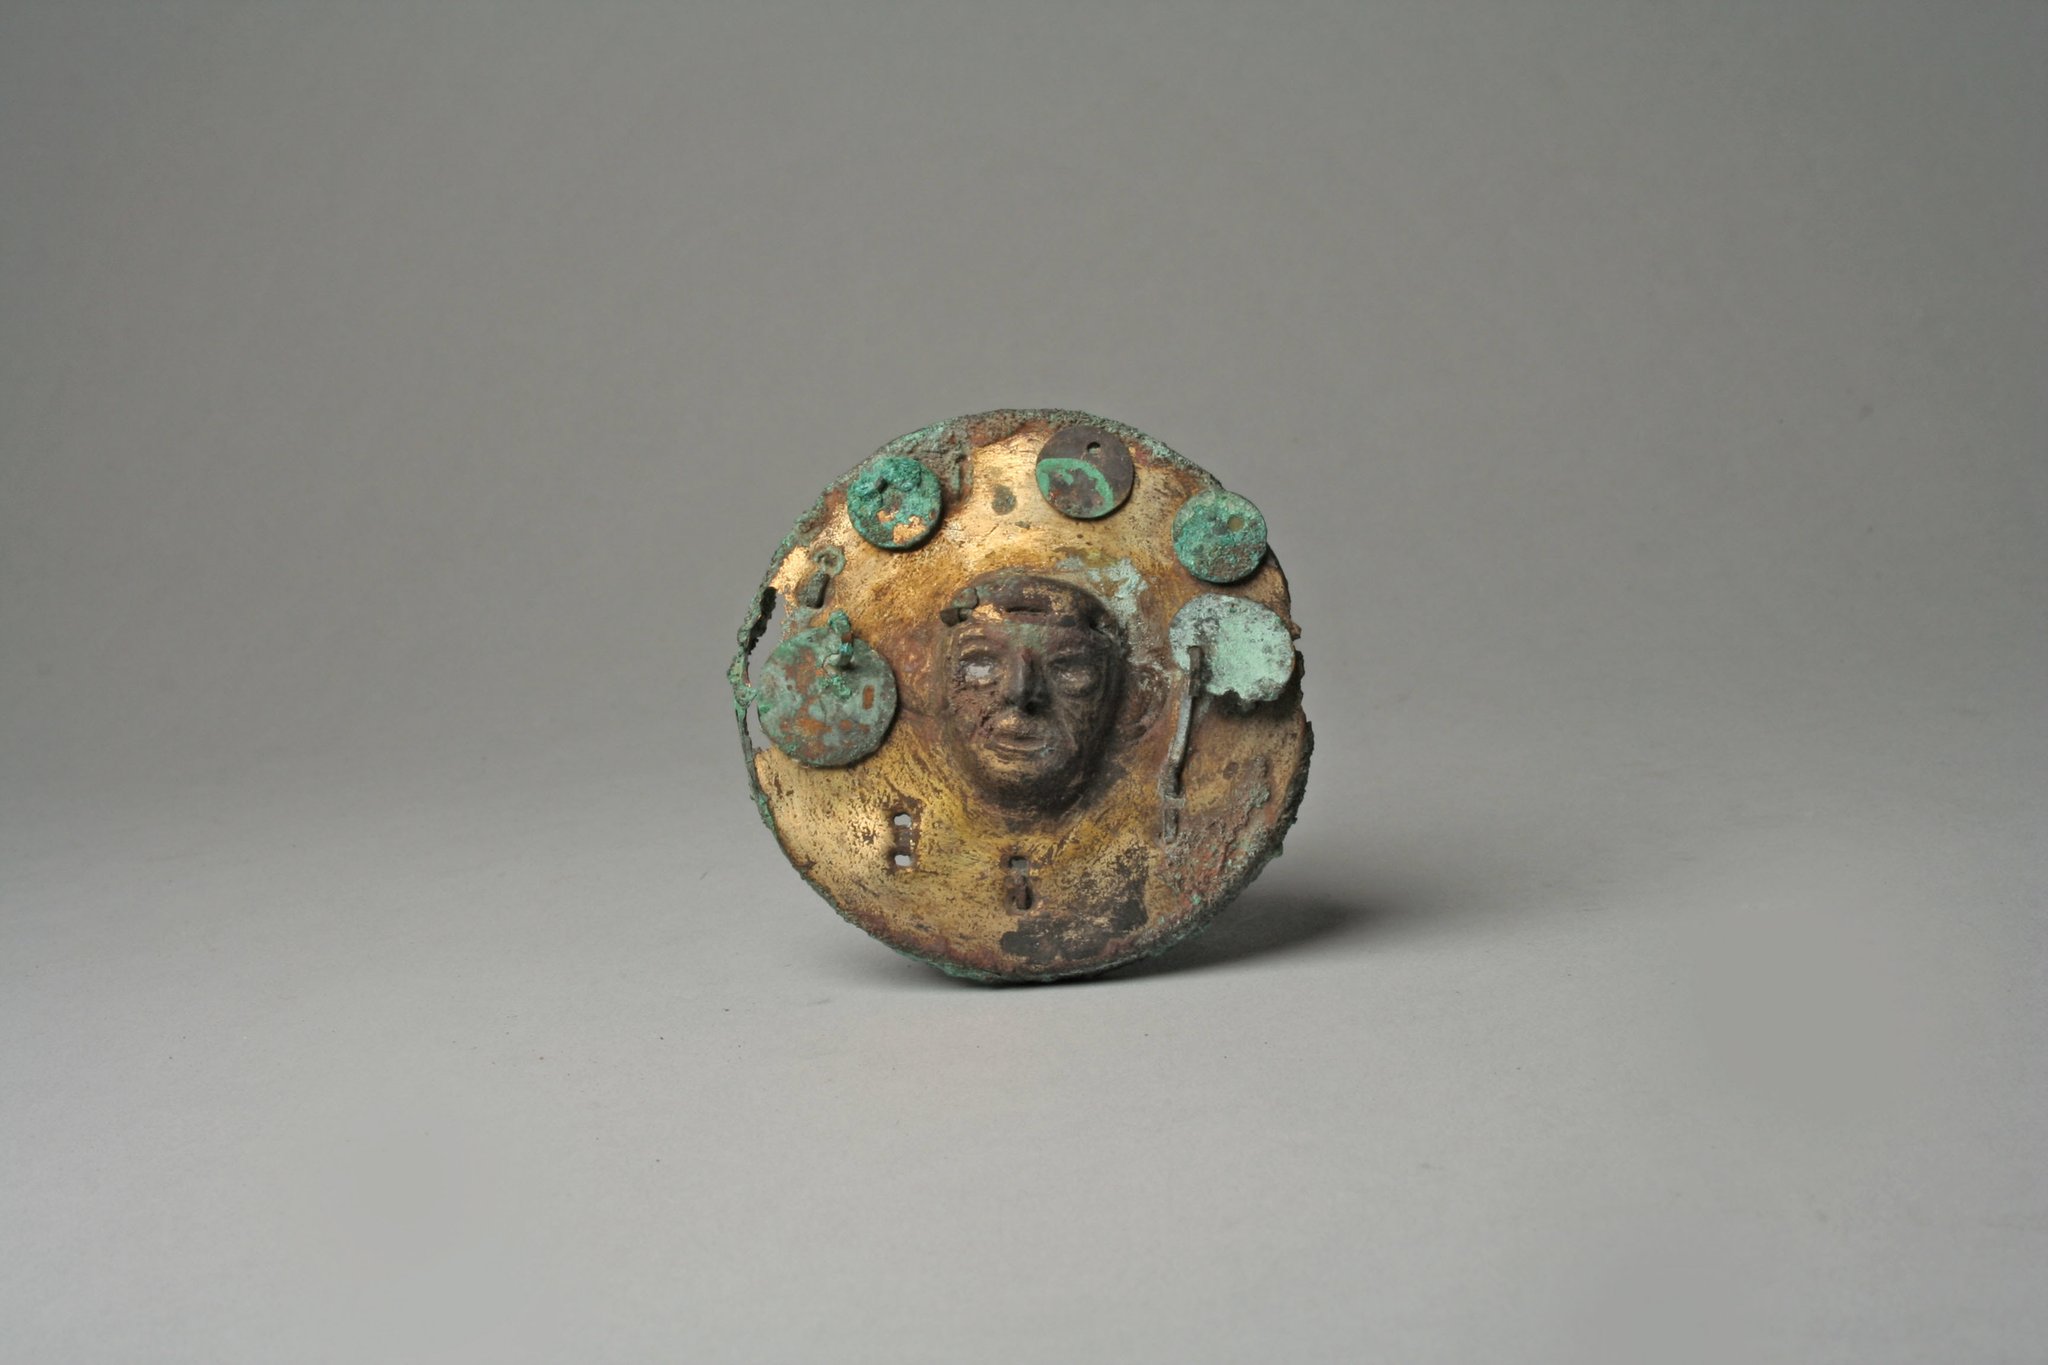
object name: earflare frontal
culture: moche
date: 501-700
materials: gilt copper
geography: peru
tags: faces